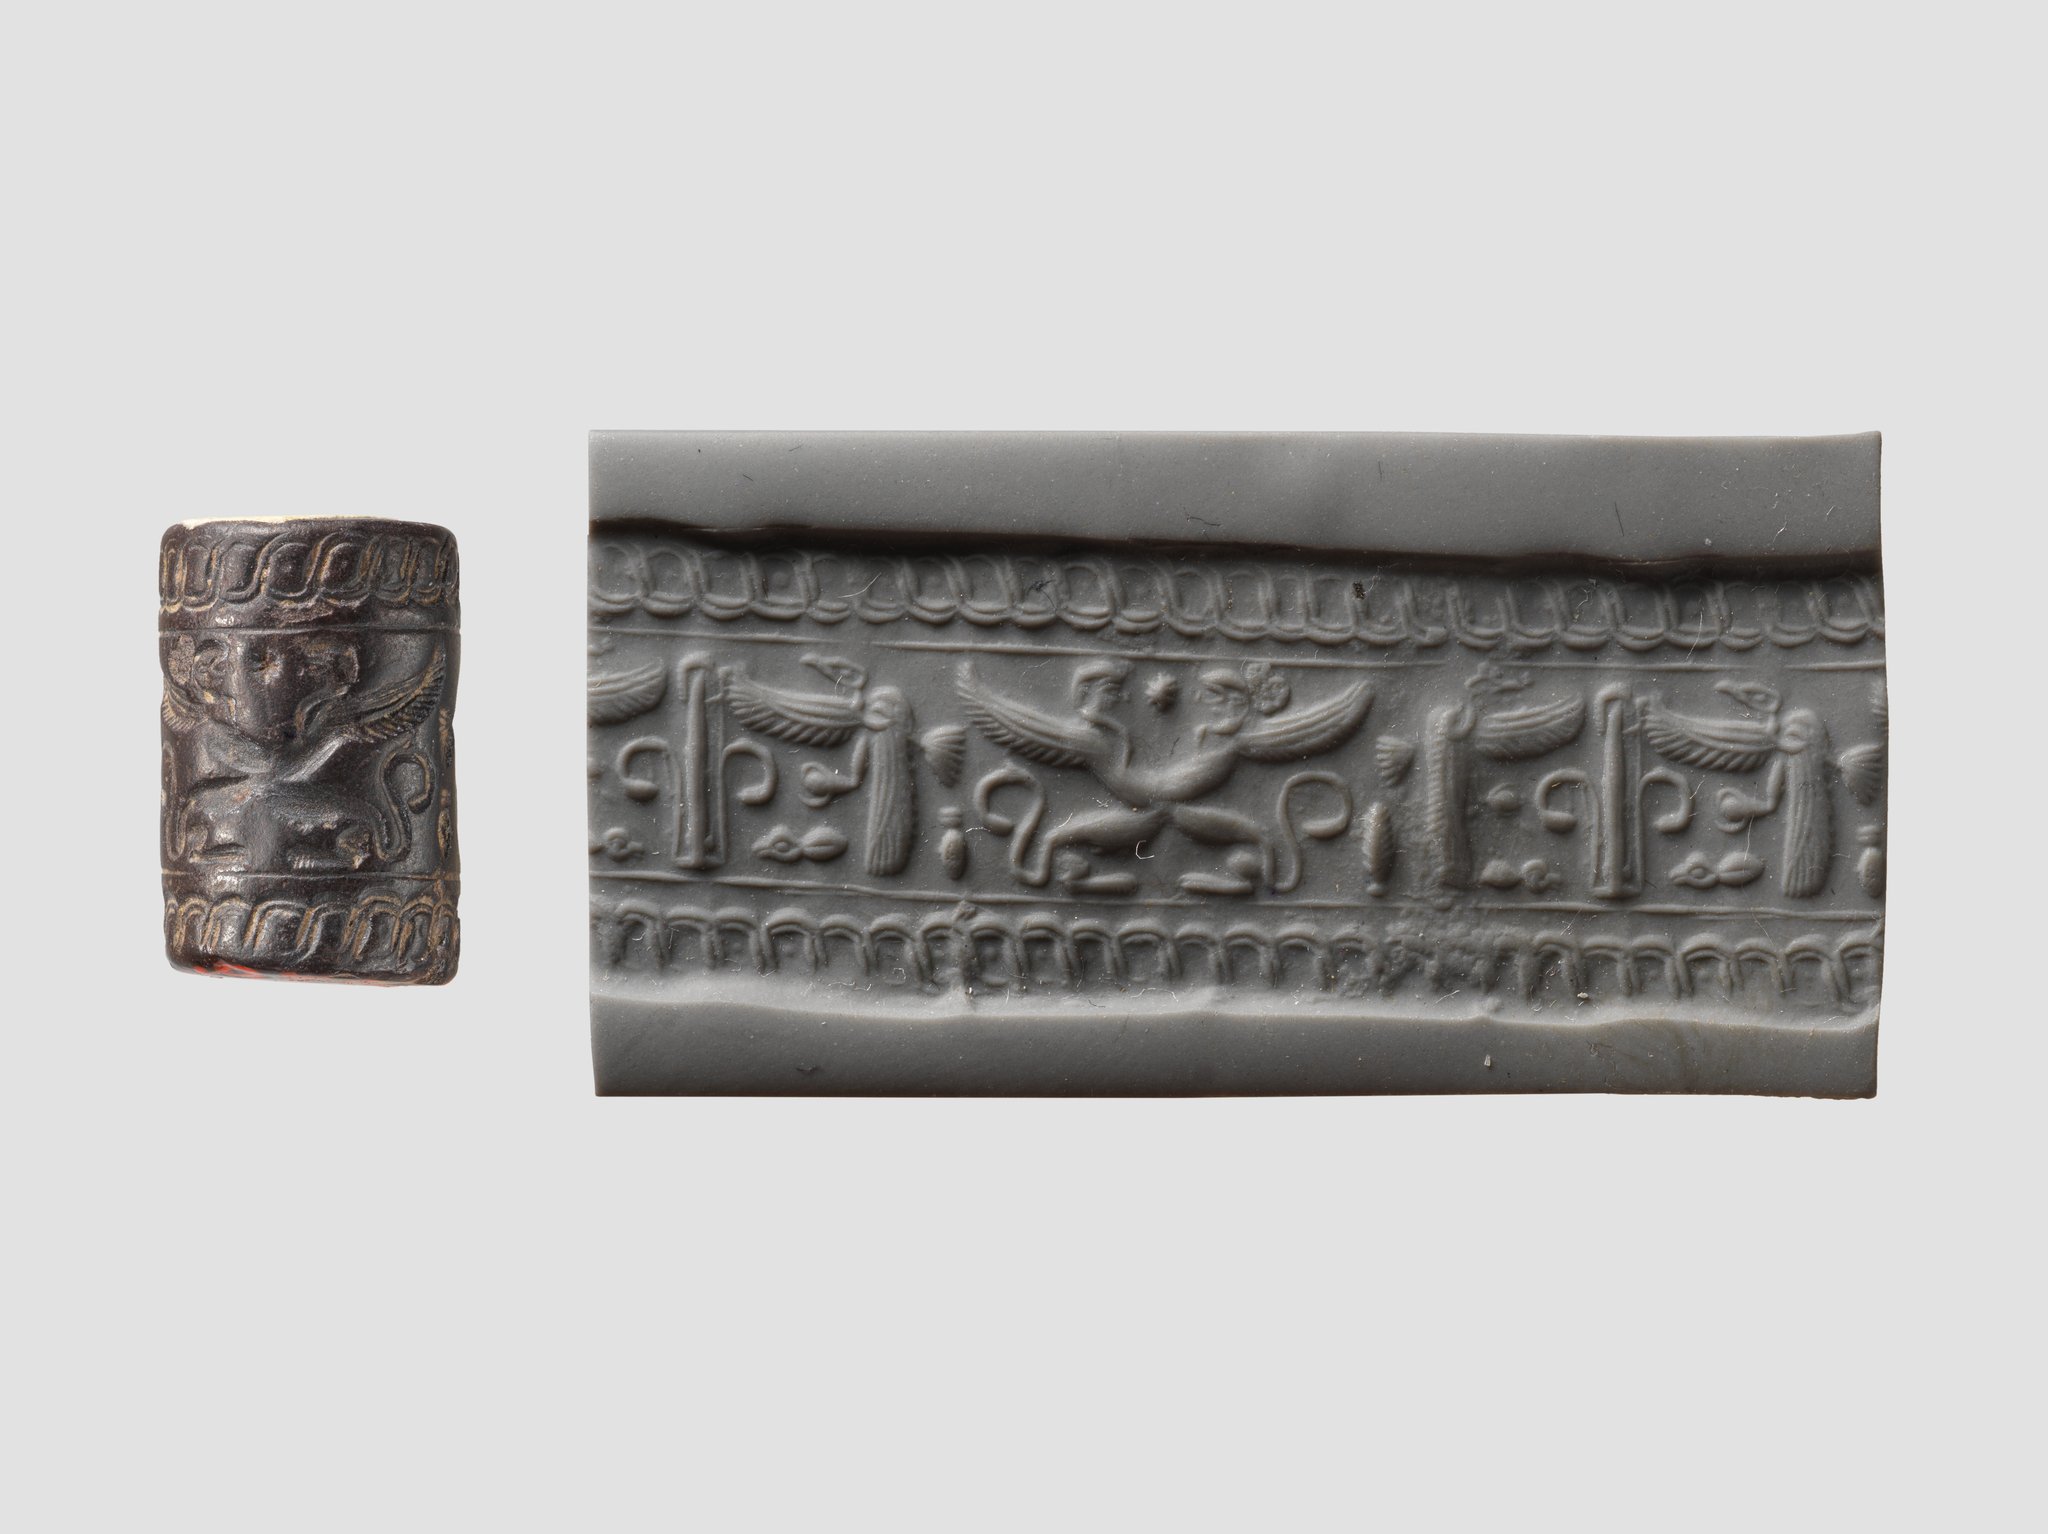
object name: cylinder seal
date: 1720-1650 BCE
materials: mineral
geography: syria